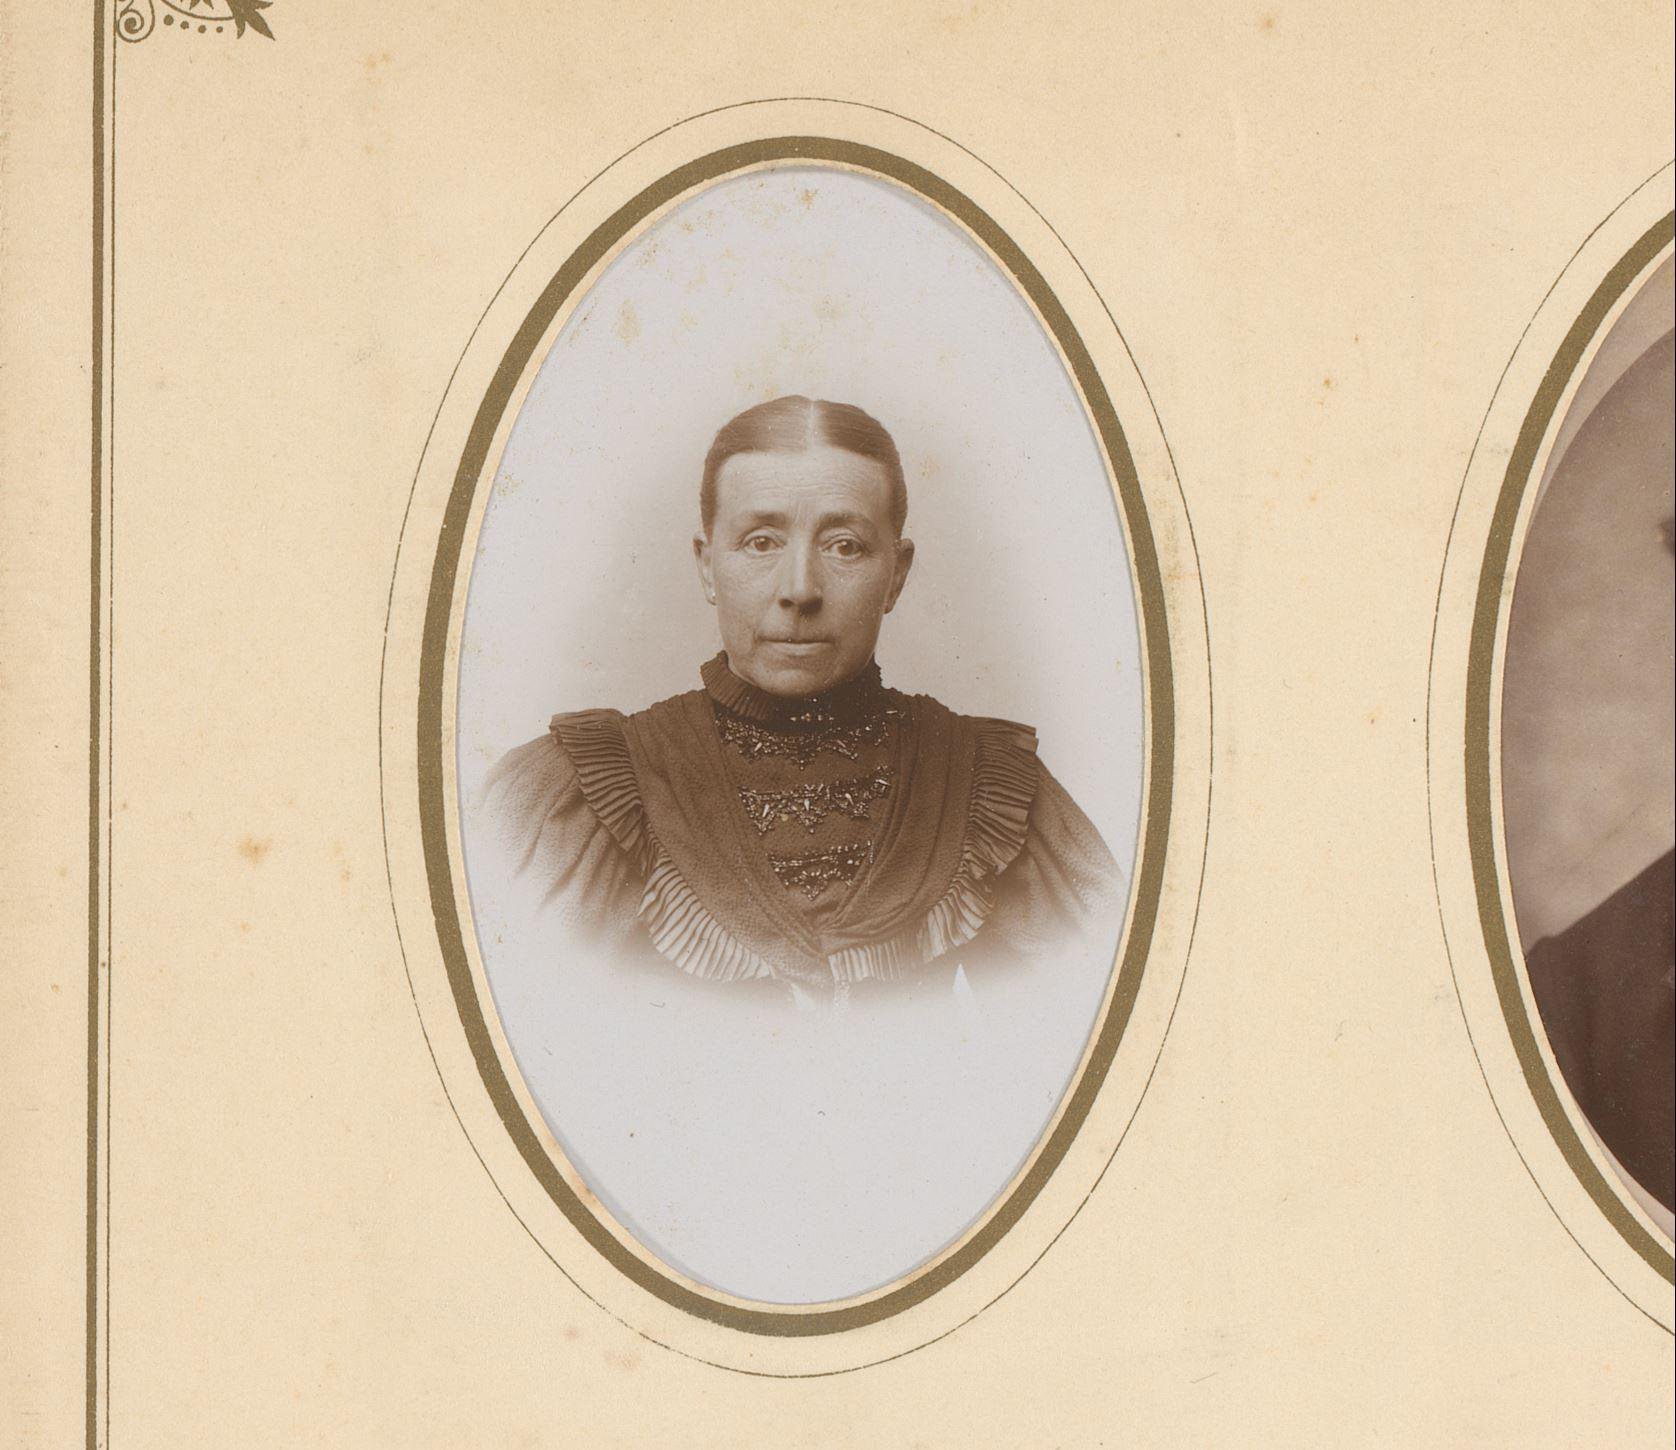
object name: album leaf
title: Portret van een vrouw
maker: johan gerard lubbers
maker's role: fotograaf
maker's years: 1849-1923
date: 1891-1907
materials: cardboard, photographic support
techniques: collodion silver print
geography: rotterdam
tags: historical persons - bb - woman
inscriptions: inscription: ‘J.G. Lubbers/ Photographe/ van der Takstraat 8/ Rotterdam./ De plaat blijft voor nabestelling bewaard./ Vergrootingen in ieder afmeting tot levensgroot.’, number: ‘w. 46’